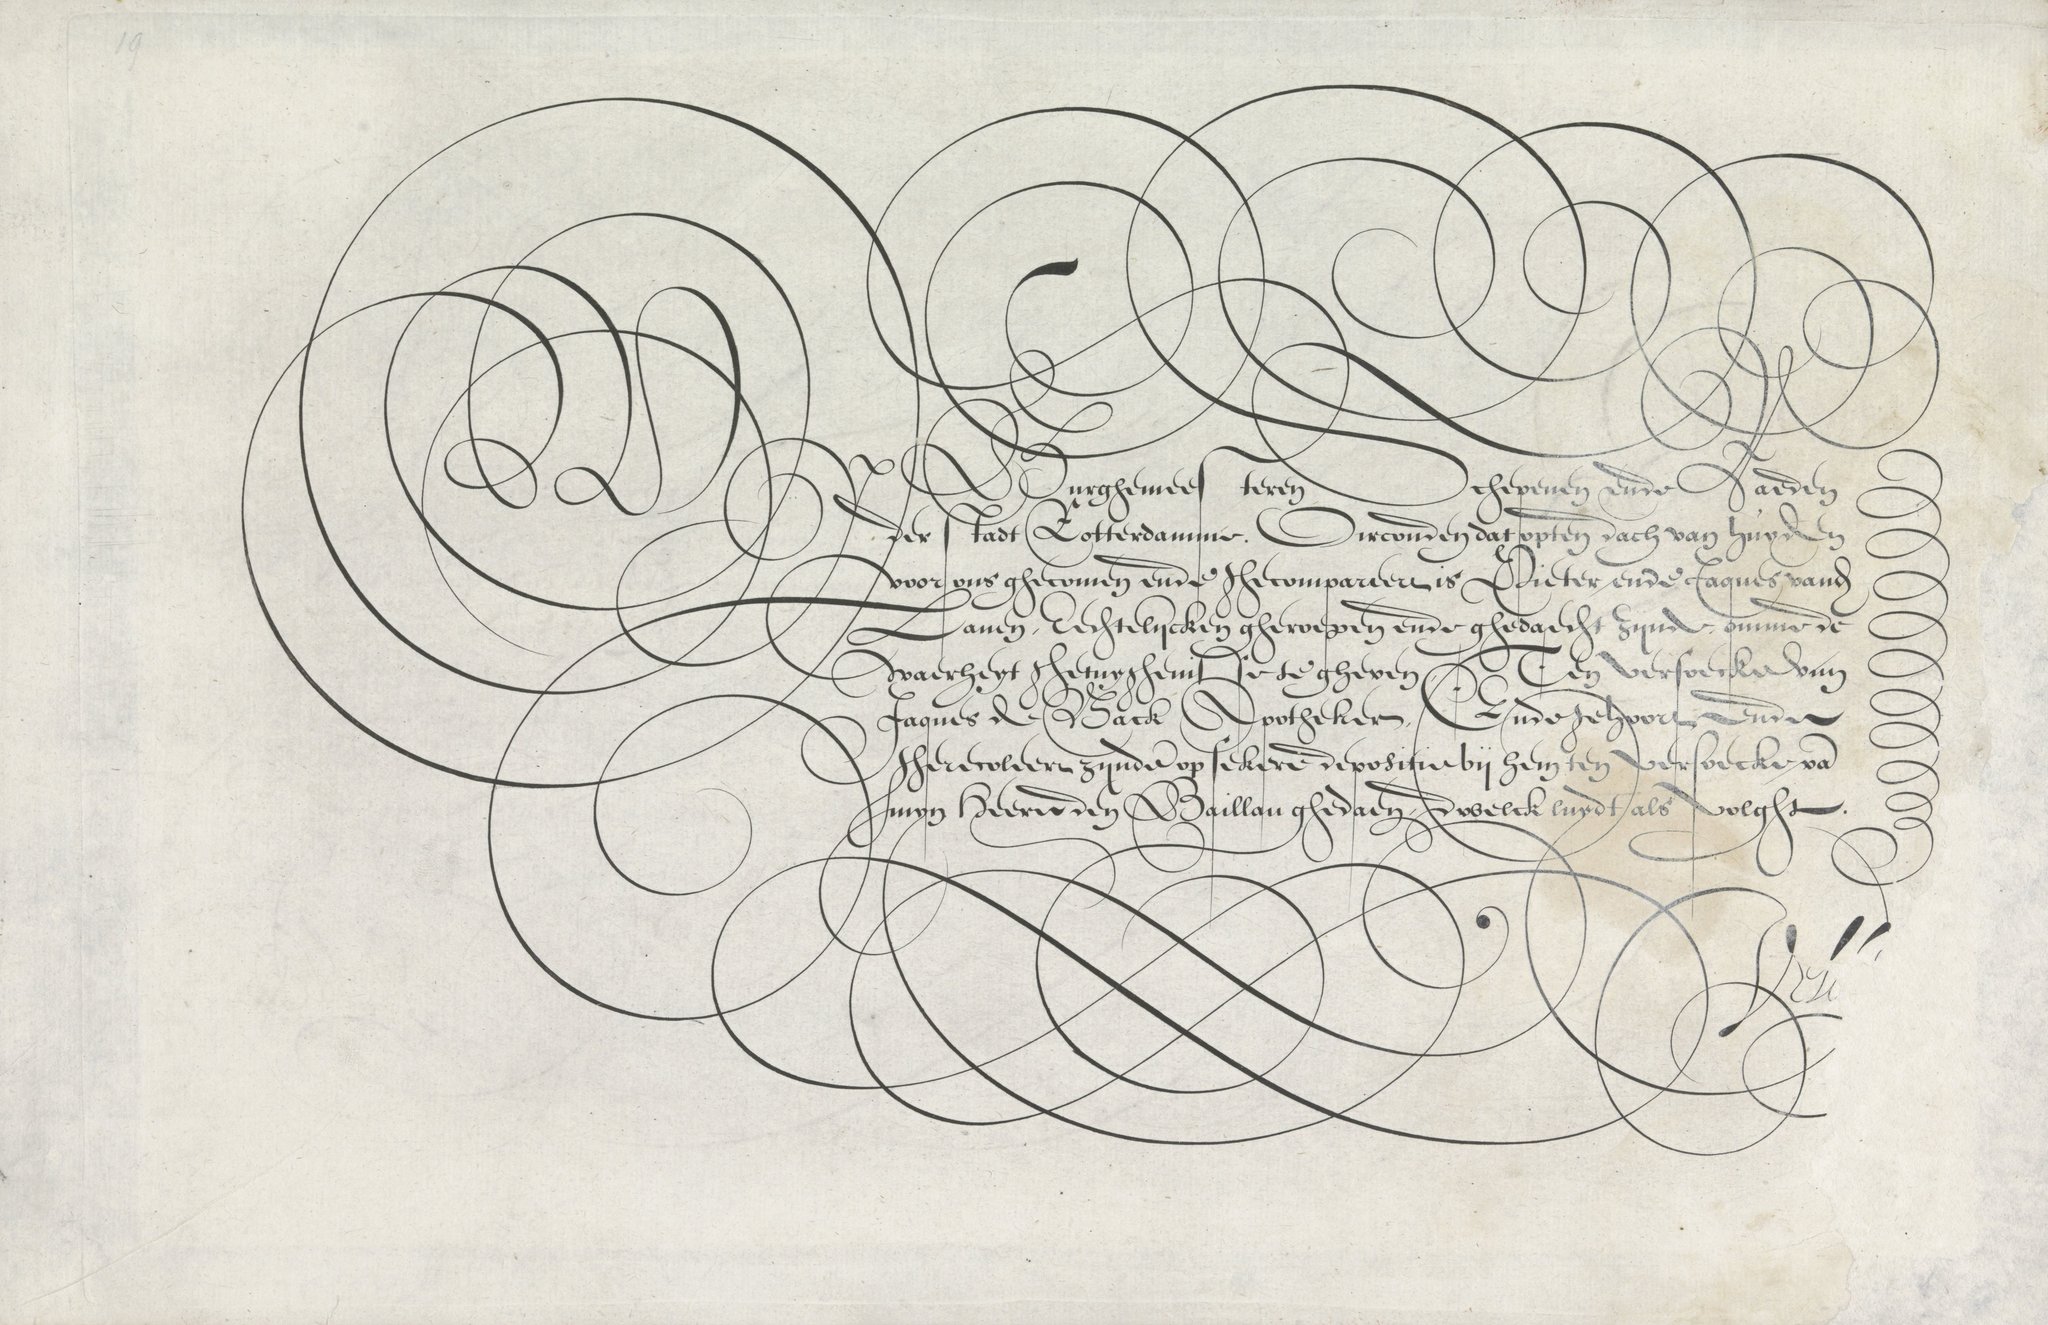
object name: ornament print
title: Schrijfvoorbeeld: De Burghemeesteren (...)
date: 1605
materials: paper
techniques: engraving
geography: haarlem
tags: calligraphy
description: Schrijfvoorbeeld met acht regels tekst in het Nederlands: De Burghemeesteren Schepenen ende Raeden der stadt Rotterdamme ... De tekst is omlijst door krulwerk. De prent maakt deel uit van een album.